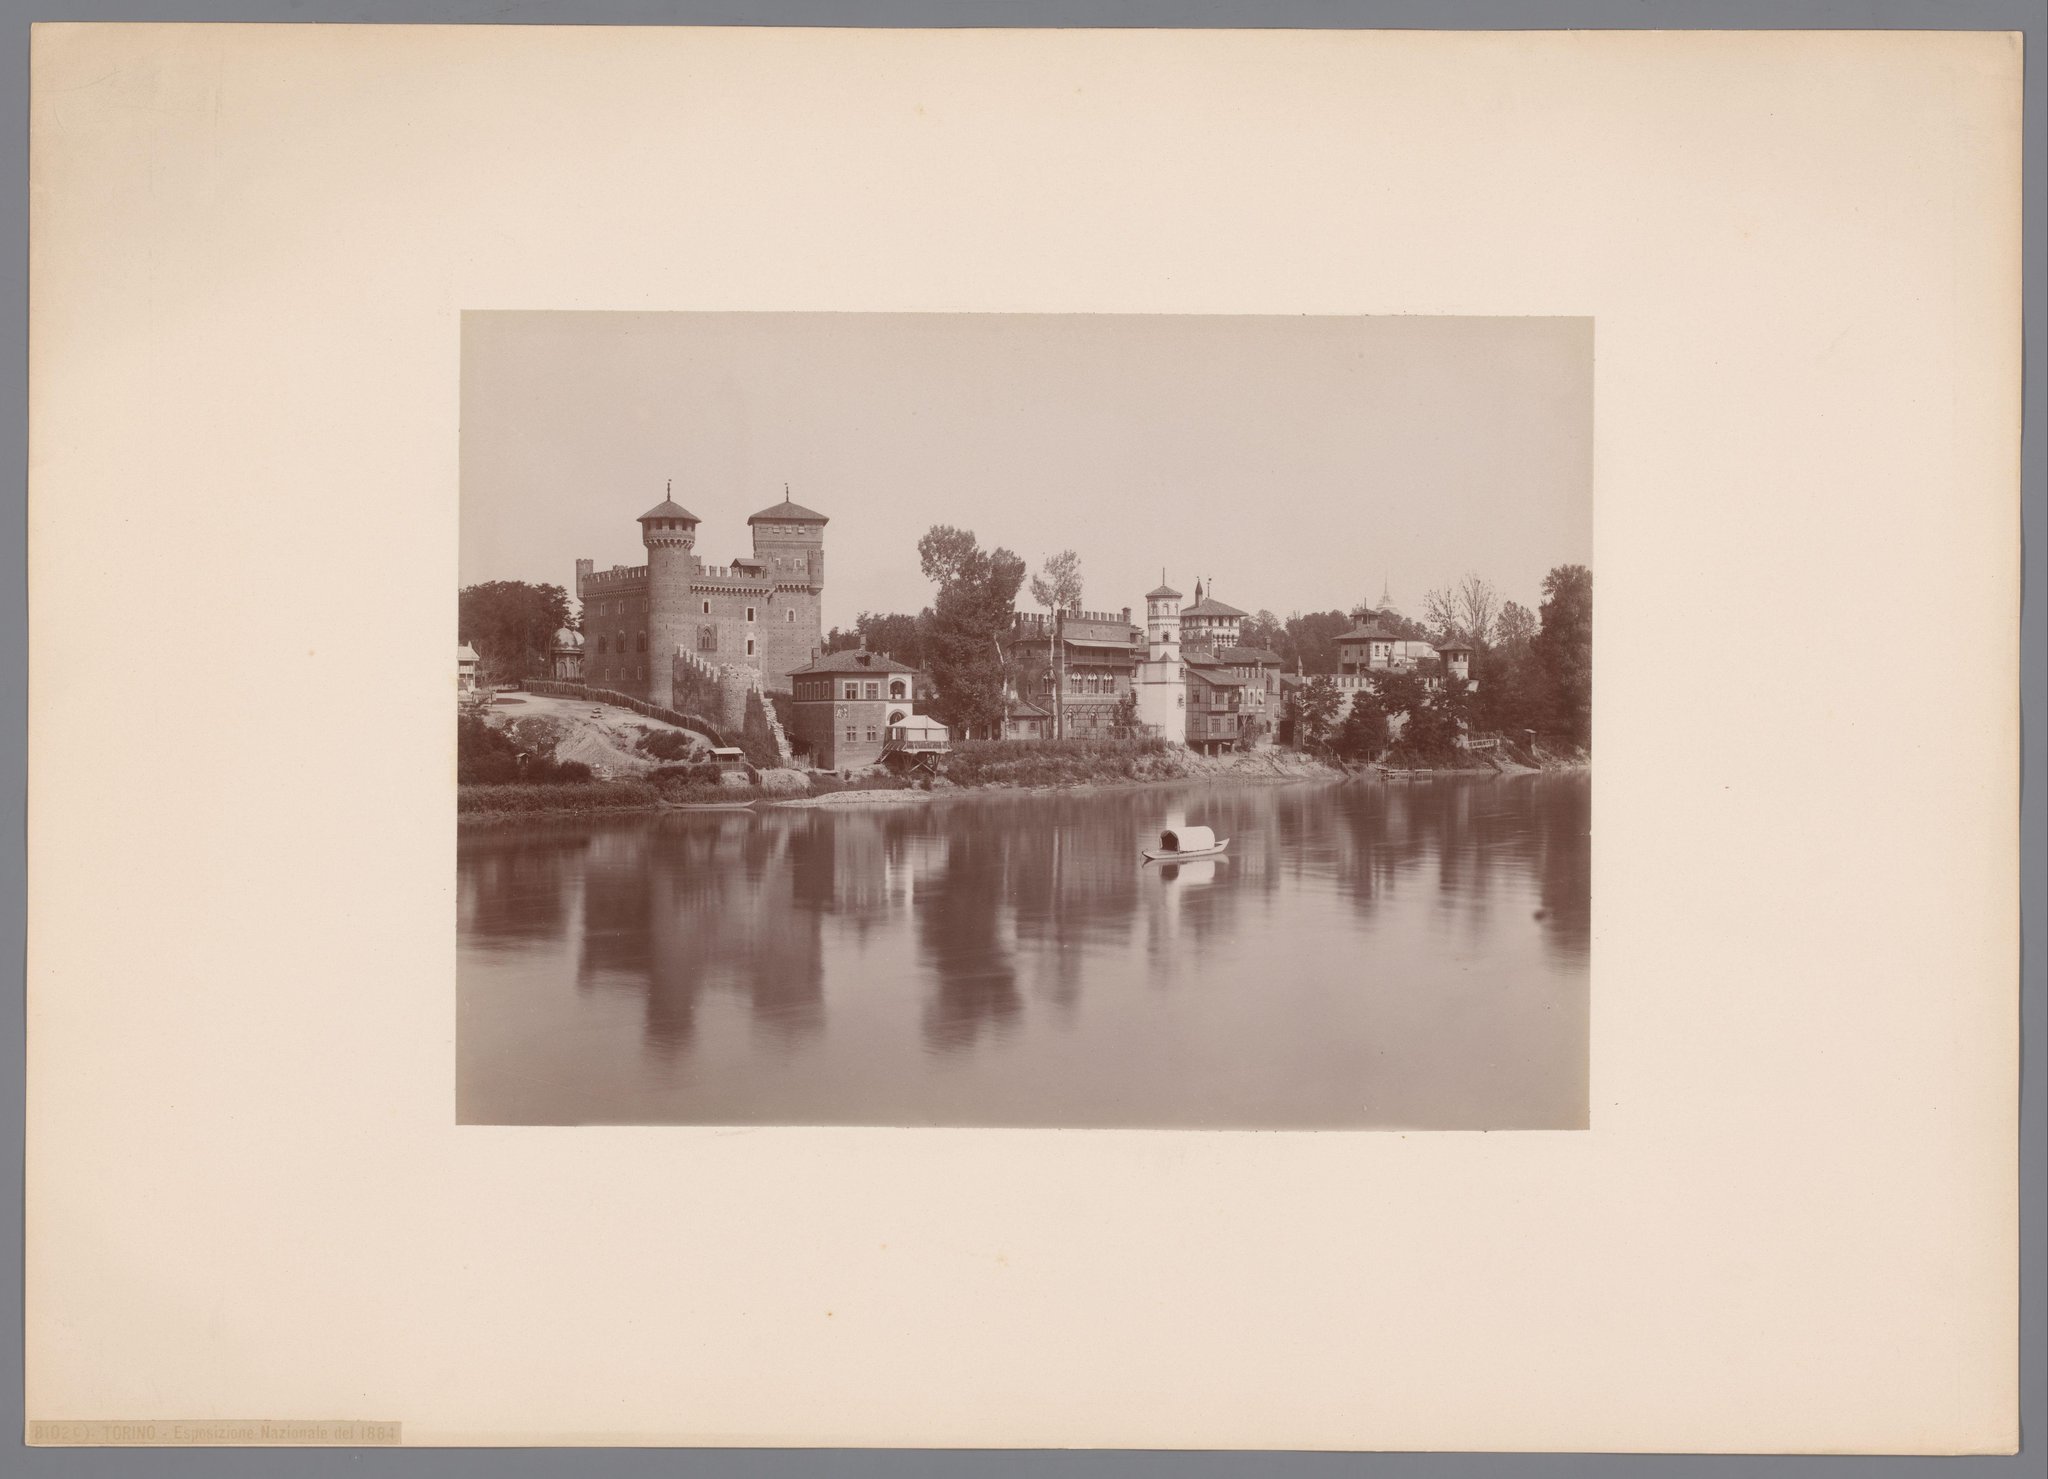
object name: photograph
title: Esposizione Nazionale del 1884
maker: carlo brogi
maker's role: fotograaf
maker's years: 1850-1925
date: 1884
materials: cardboard, paper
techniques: albumen print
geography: florence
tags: castle, fictitious scene ~ anonymous historical person(s)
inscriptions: number: ‘8102 c)’, number: ‘87’